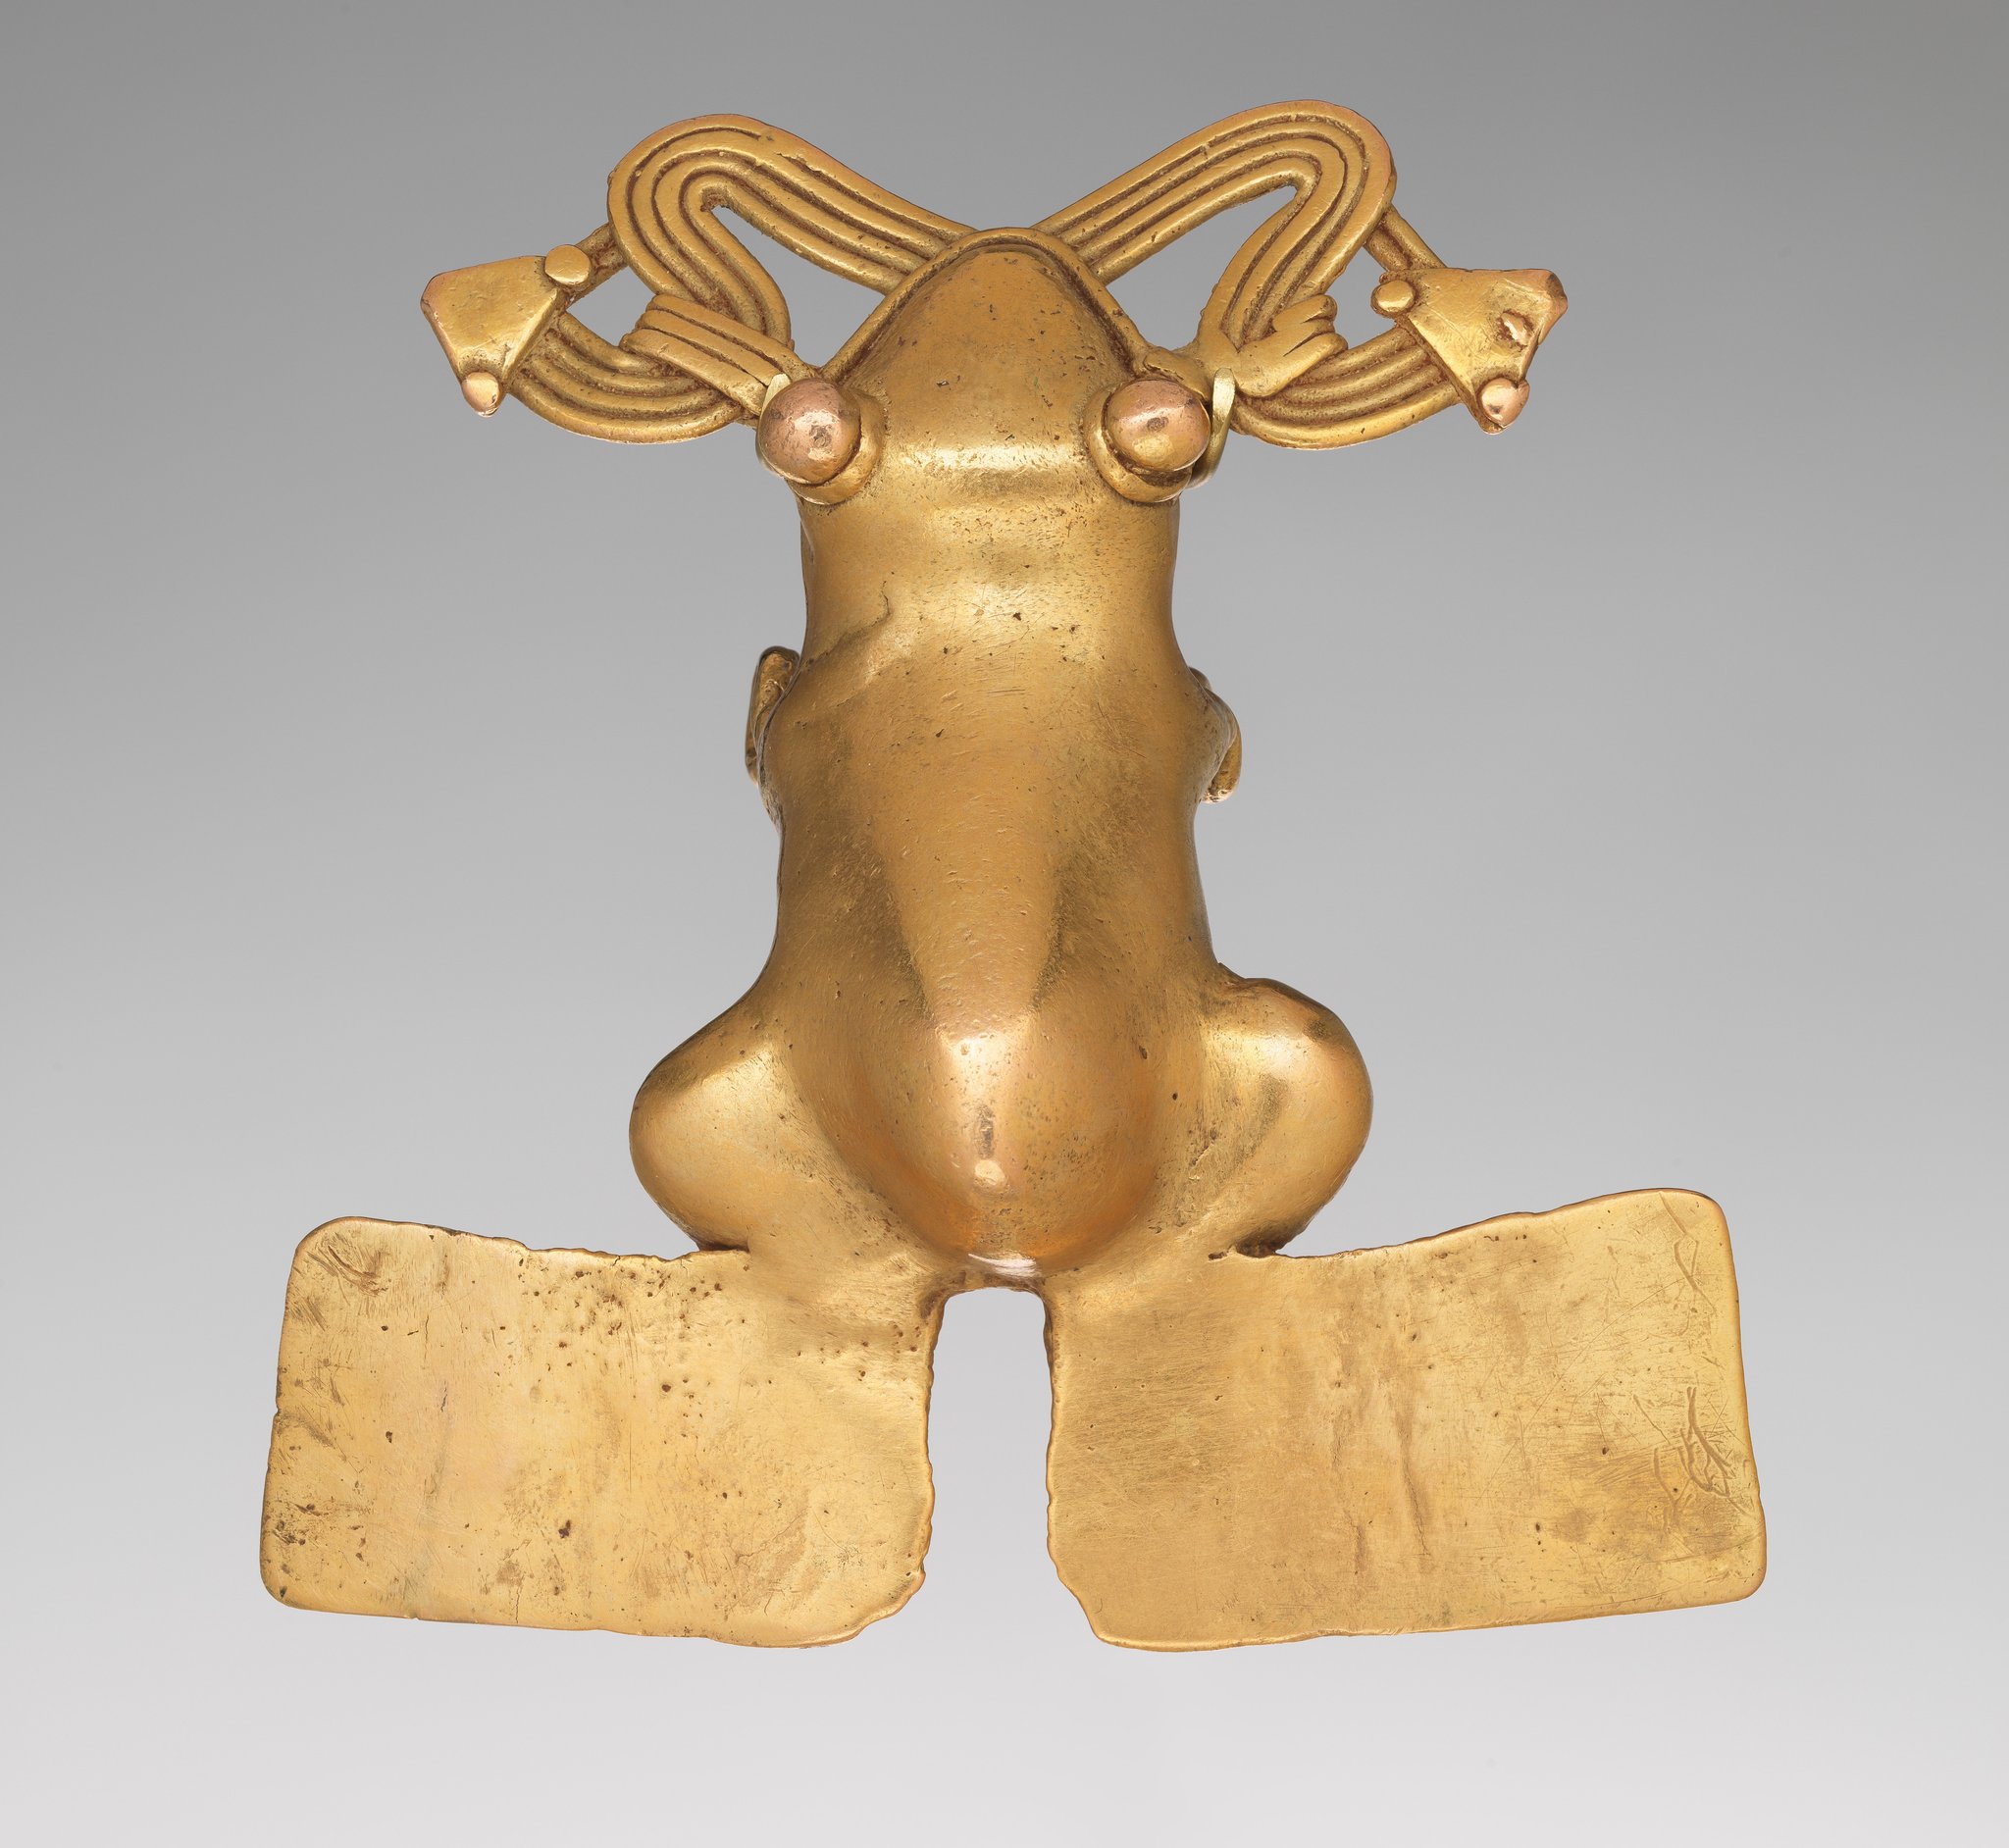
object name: frog pendant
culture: chiriqui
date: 1001-1600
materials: gold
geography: costa rica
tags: frogs